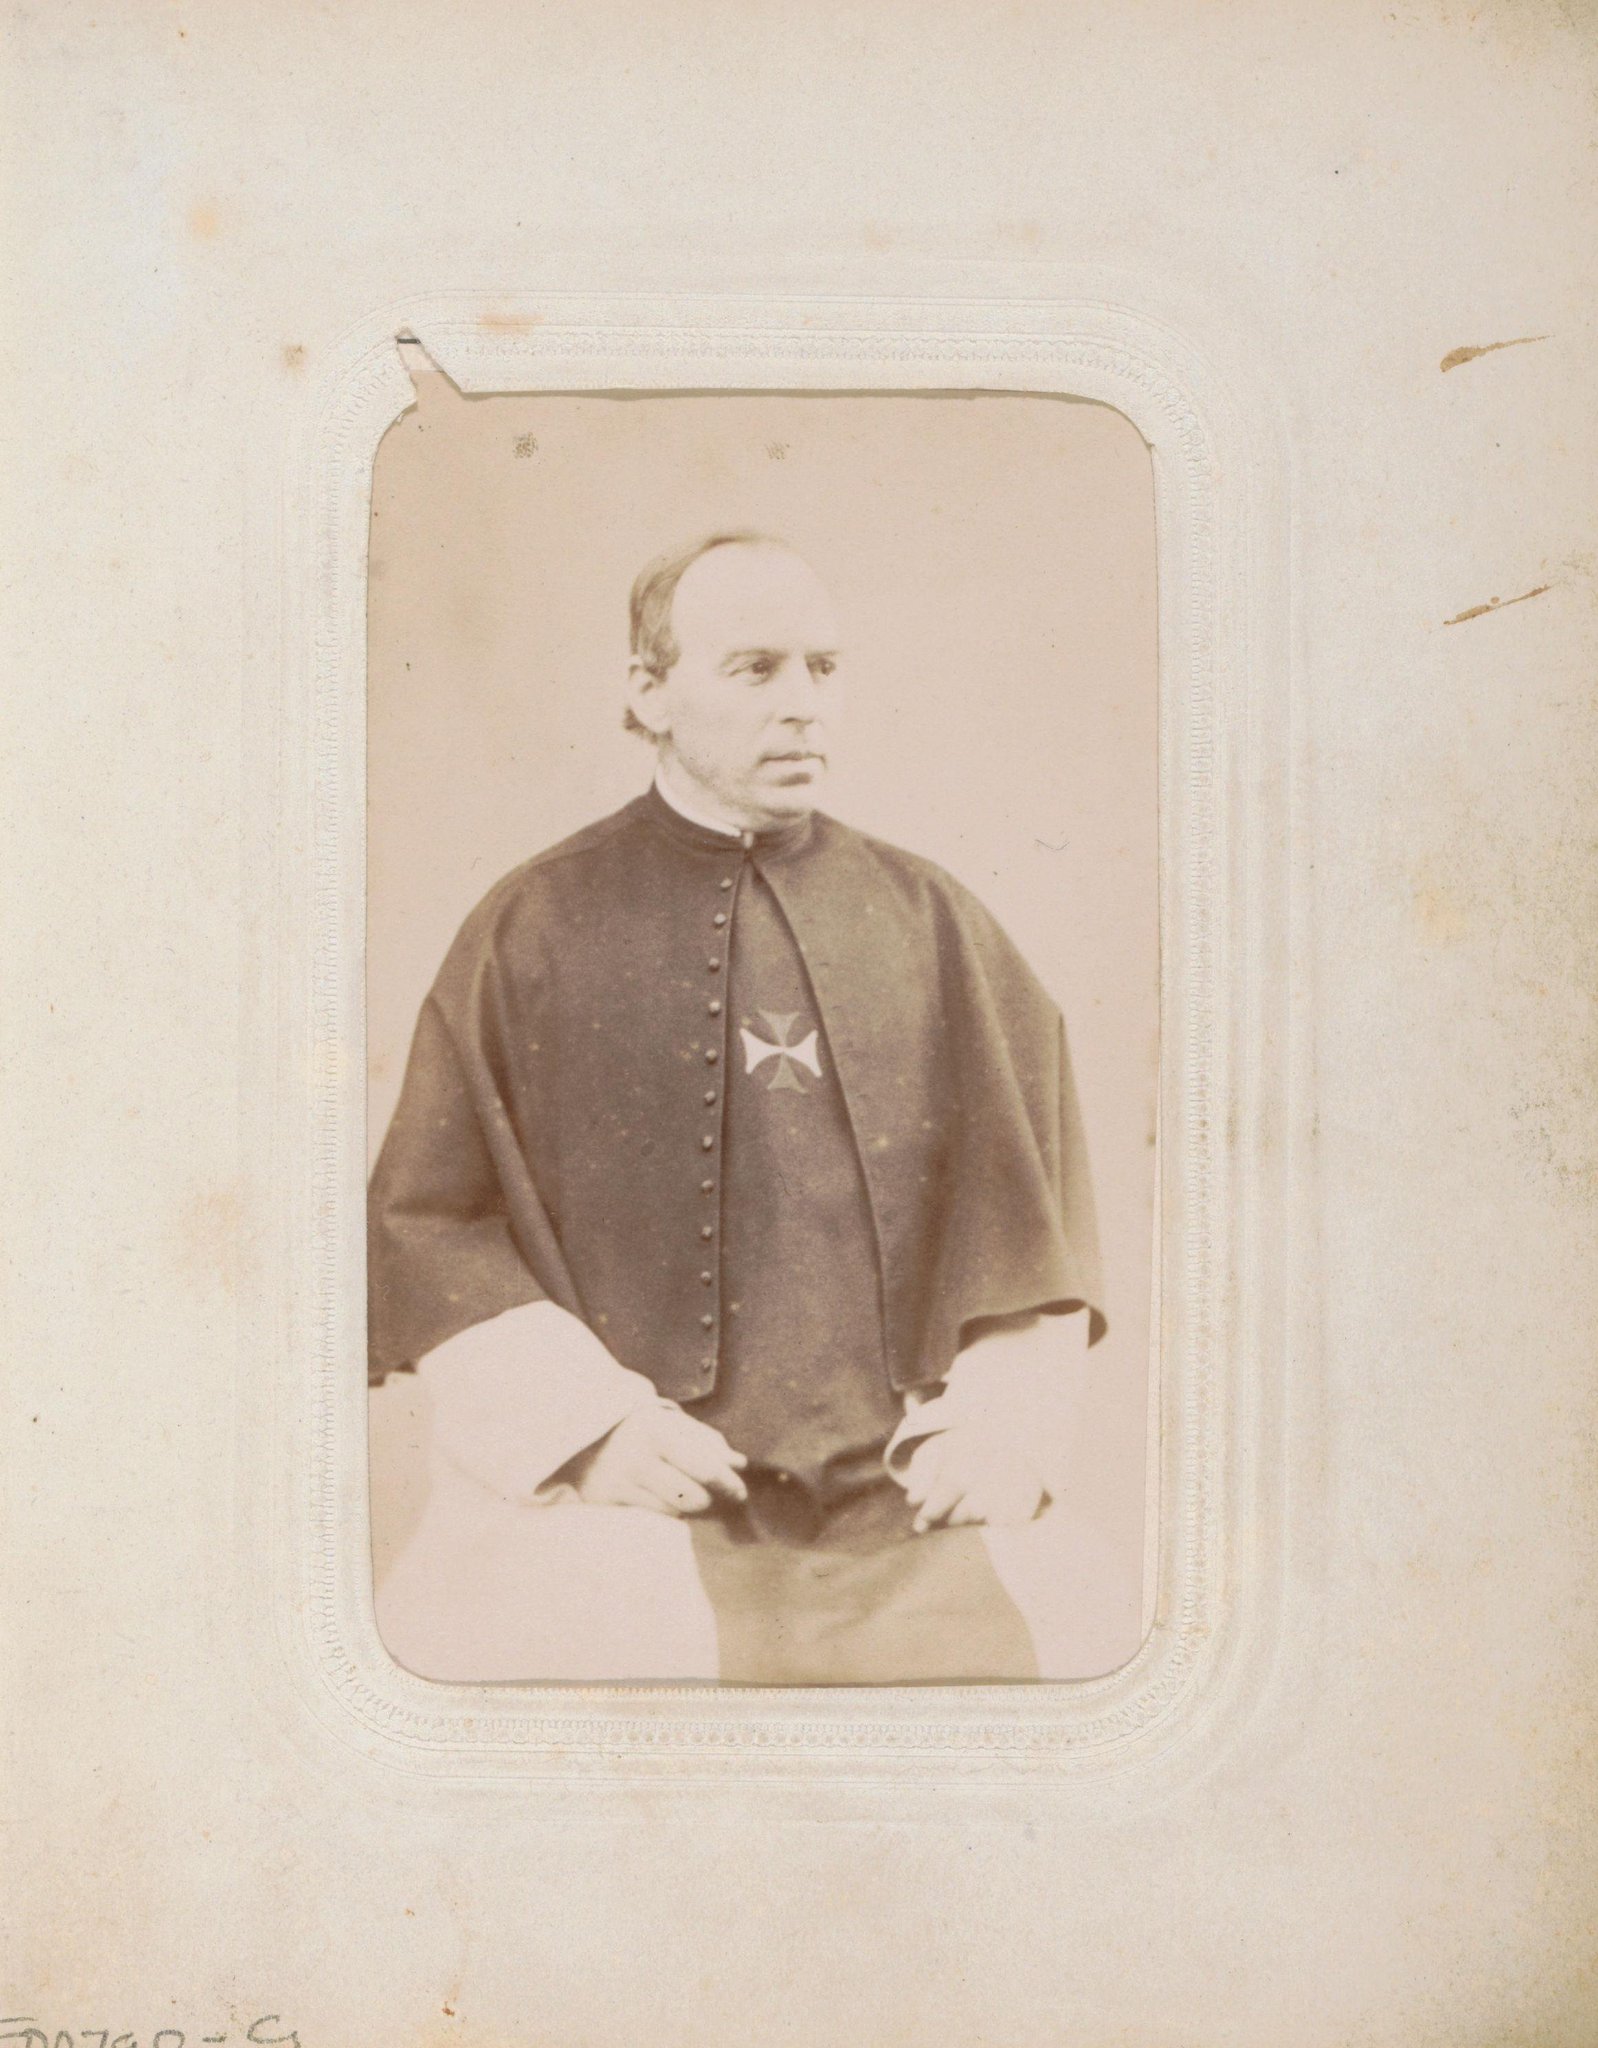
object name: carte de visite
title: Portret van een geestelijke met een Maltezer kruis op de borst en een pelerine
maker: johannes wilhelmus franciscus offenberg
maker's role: fotograaf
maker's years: 1839-1919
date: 1867-1888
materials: cardboard, paper, photographic support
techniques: albumen print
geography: amsterdam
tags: priest (roman catholic), specific forms of the cross (maltese cross), amsterdam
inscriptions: address: ‘Damstraat’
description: Onderdeel van Fotoalbum met 26 cartes-de-visite van rooms-katholieke geestelijken.